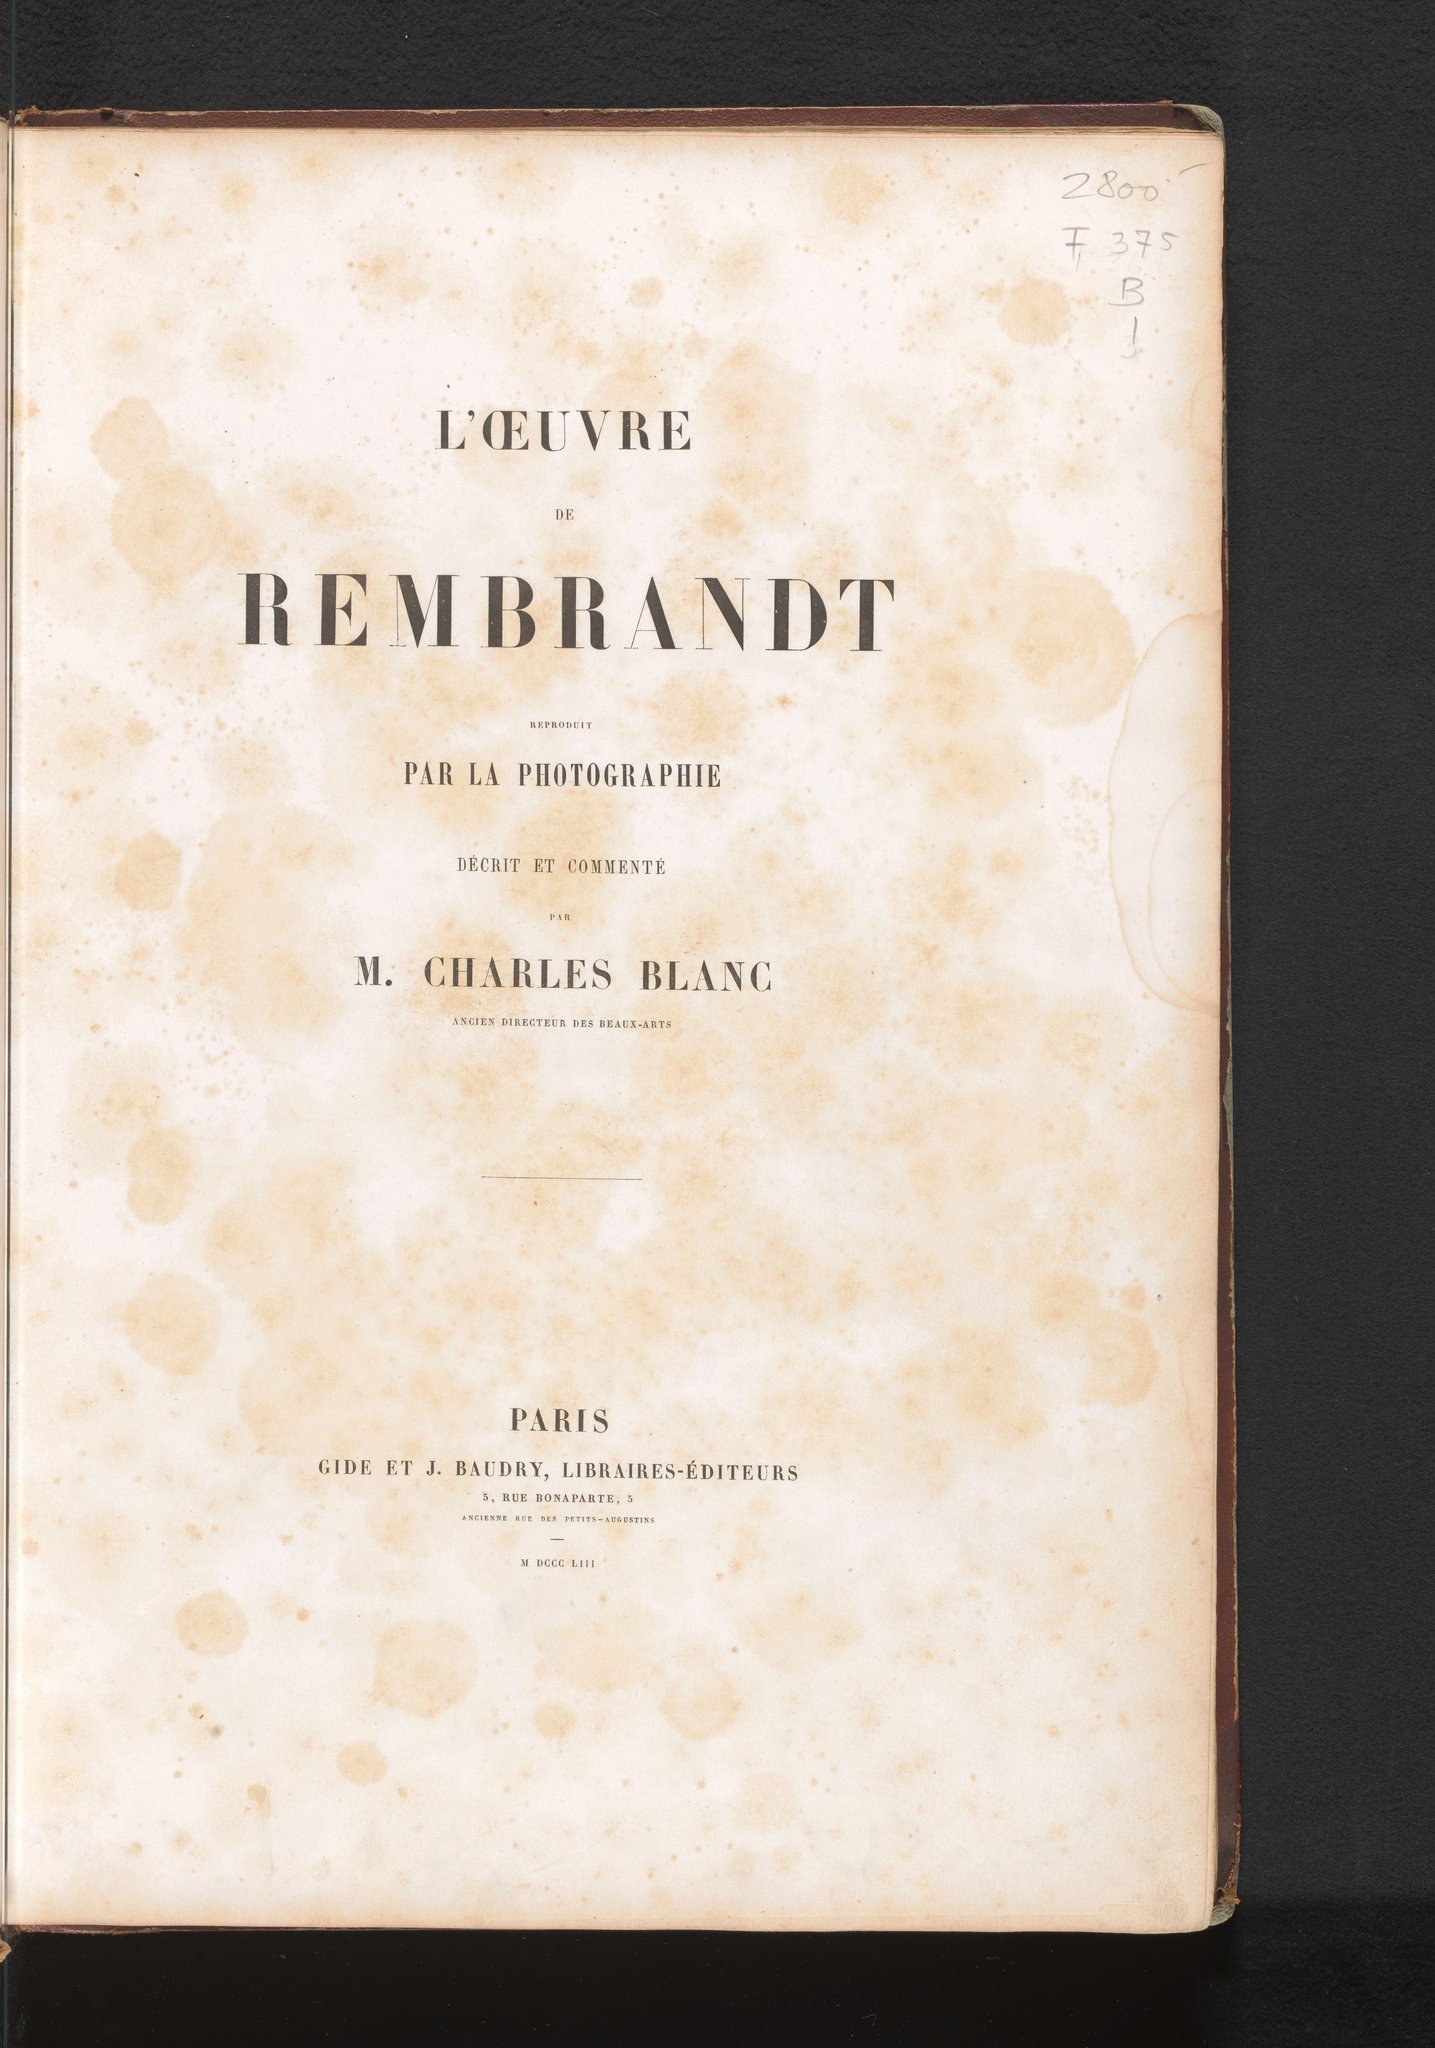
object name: book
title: L'oeuvre de Rembrandt reproduit par la photographie / décrit et commenté par Charles Blanc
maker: charles blanc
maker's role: graveur, kunsthistoricus, schrijver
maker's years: 1813-1882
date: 1853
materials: cardboard, leather, linen, paper, photographic support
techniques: printing, salted paper print, marbled paper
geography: paris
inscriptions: annotation: ‘foatt/ s/g 87/ folio f 90.-’, date: ‘JUNE/ 1997’